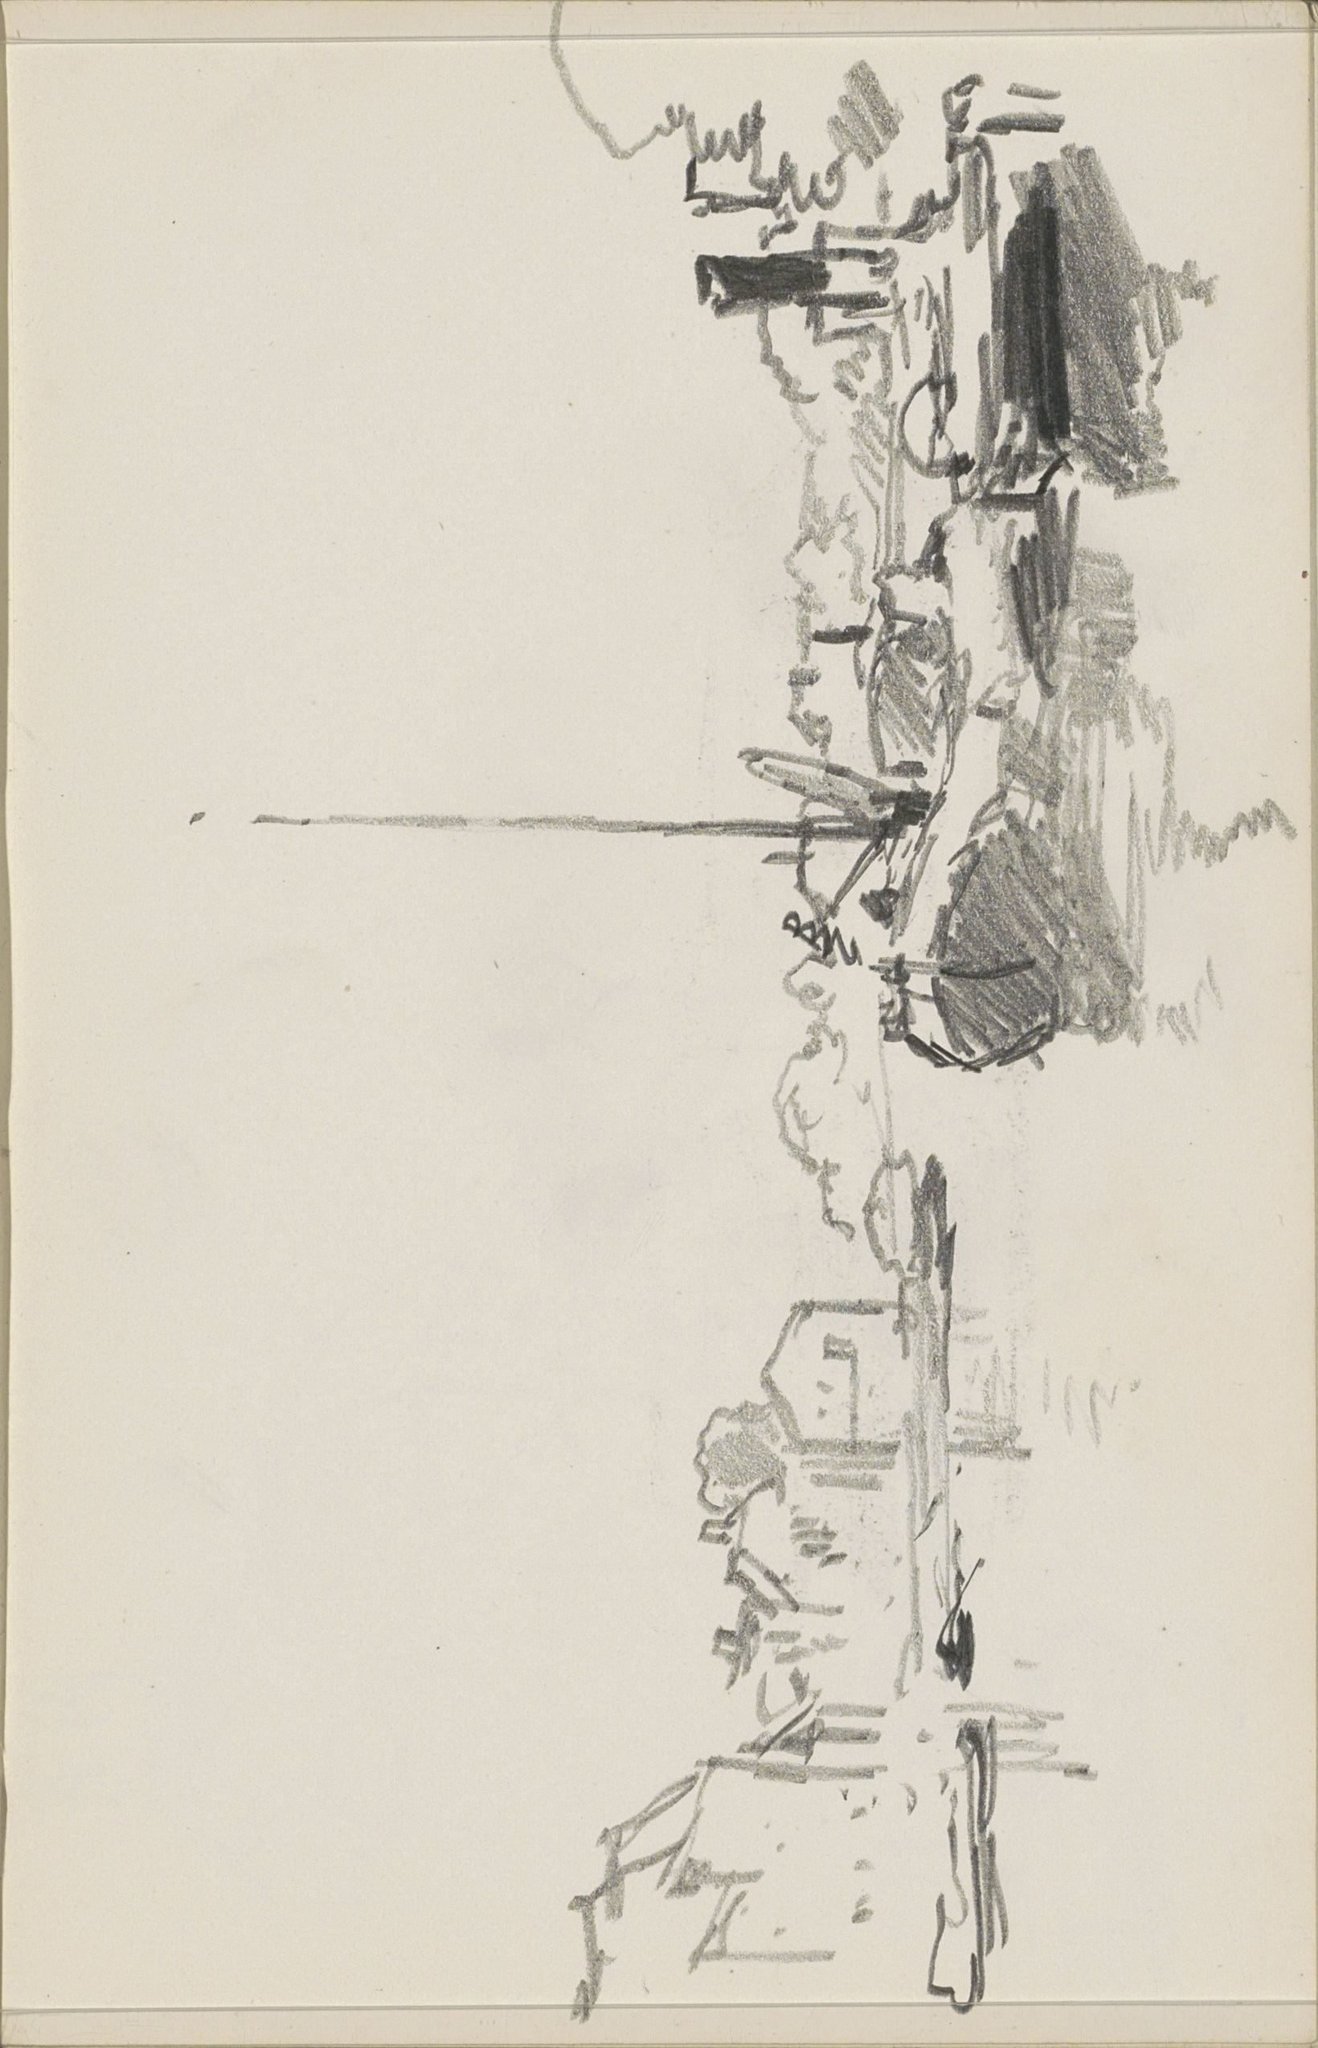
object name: sketchbook leaf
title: Boot aangemeerd aan een steiger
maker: cornelis vreedenburgh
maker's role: draughtsman, print maker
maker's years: 1880-1946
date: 1890-1946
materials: paper, pencil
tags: sailing-ship, sailing-boat, landscapes with waters, waterscapes, seascapes (in the temperate zone)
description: Op de achtergrond een rij huizen aan het water en bomen. Blad 20 recto uit een schetsboek met 41 bladen.